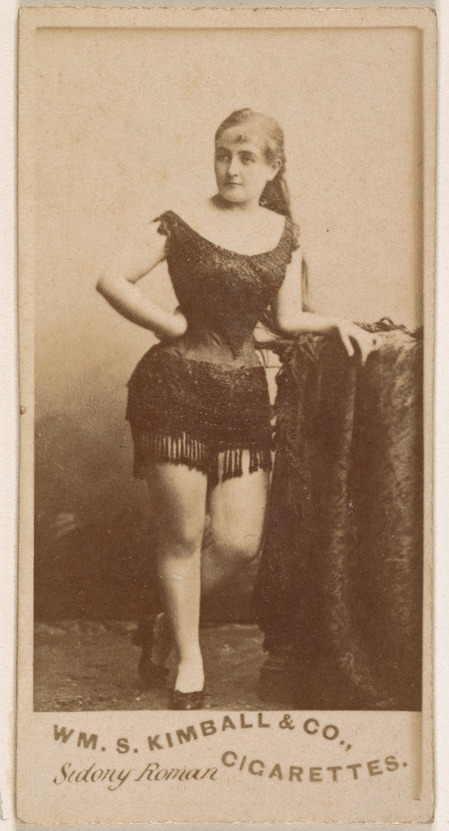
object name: photograph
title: Sidony Roman, from the Actresses series (N203) issued by Wm. S. Kimball & Co.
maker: william s. kimball & company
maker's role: publisher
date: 1889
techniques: color lithograph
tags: portraits,women,actresses